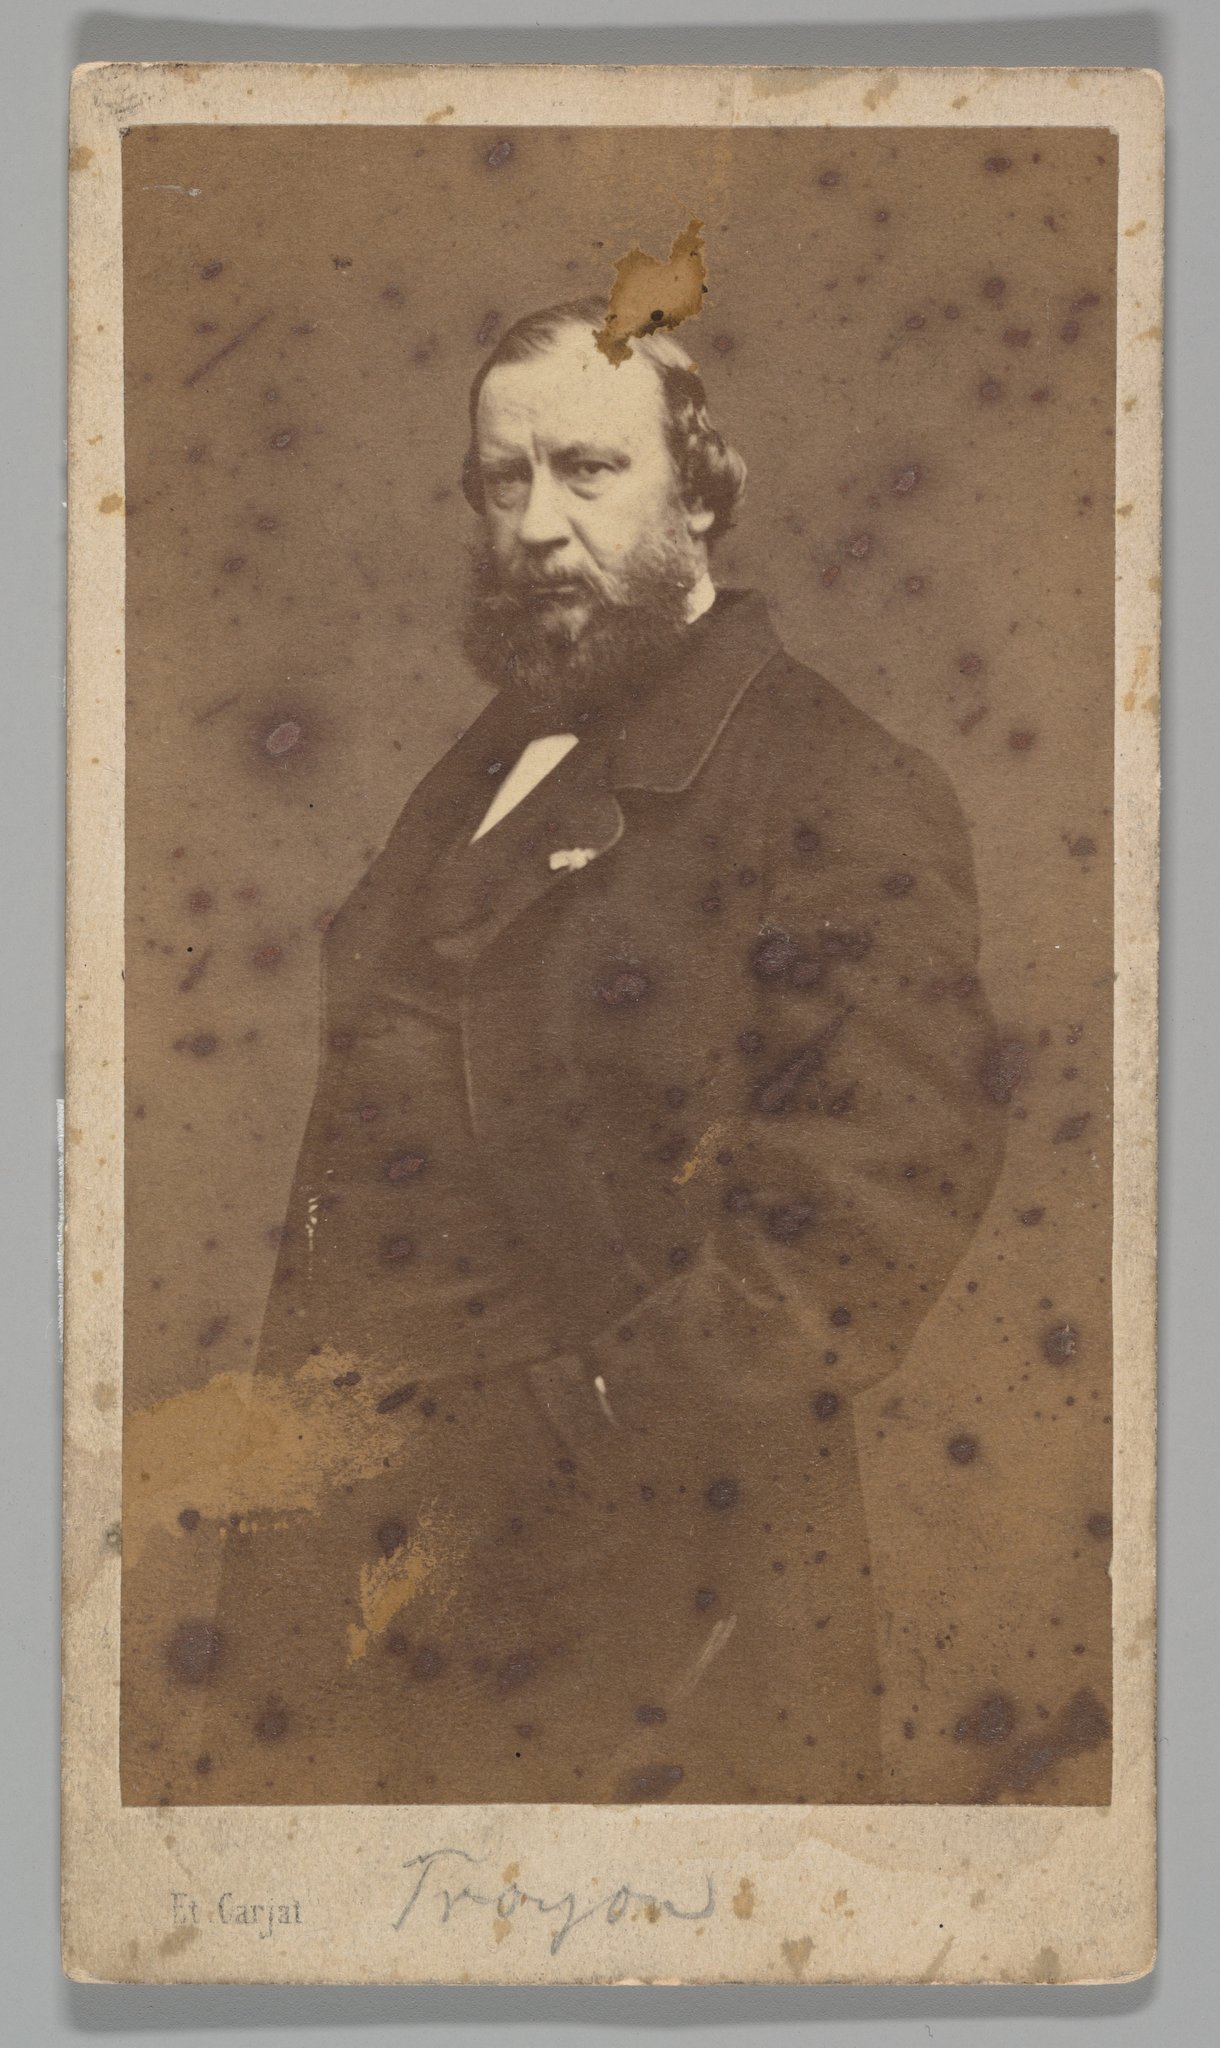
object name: carte de visite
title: [Constant Troyon]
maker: étienne carjat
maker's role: artist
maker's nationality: french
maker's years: 1828-1906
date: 1860-1869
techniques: albumen silver print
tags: men,portraits